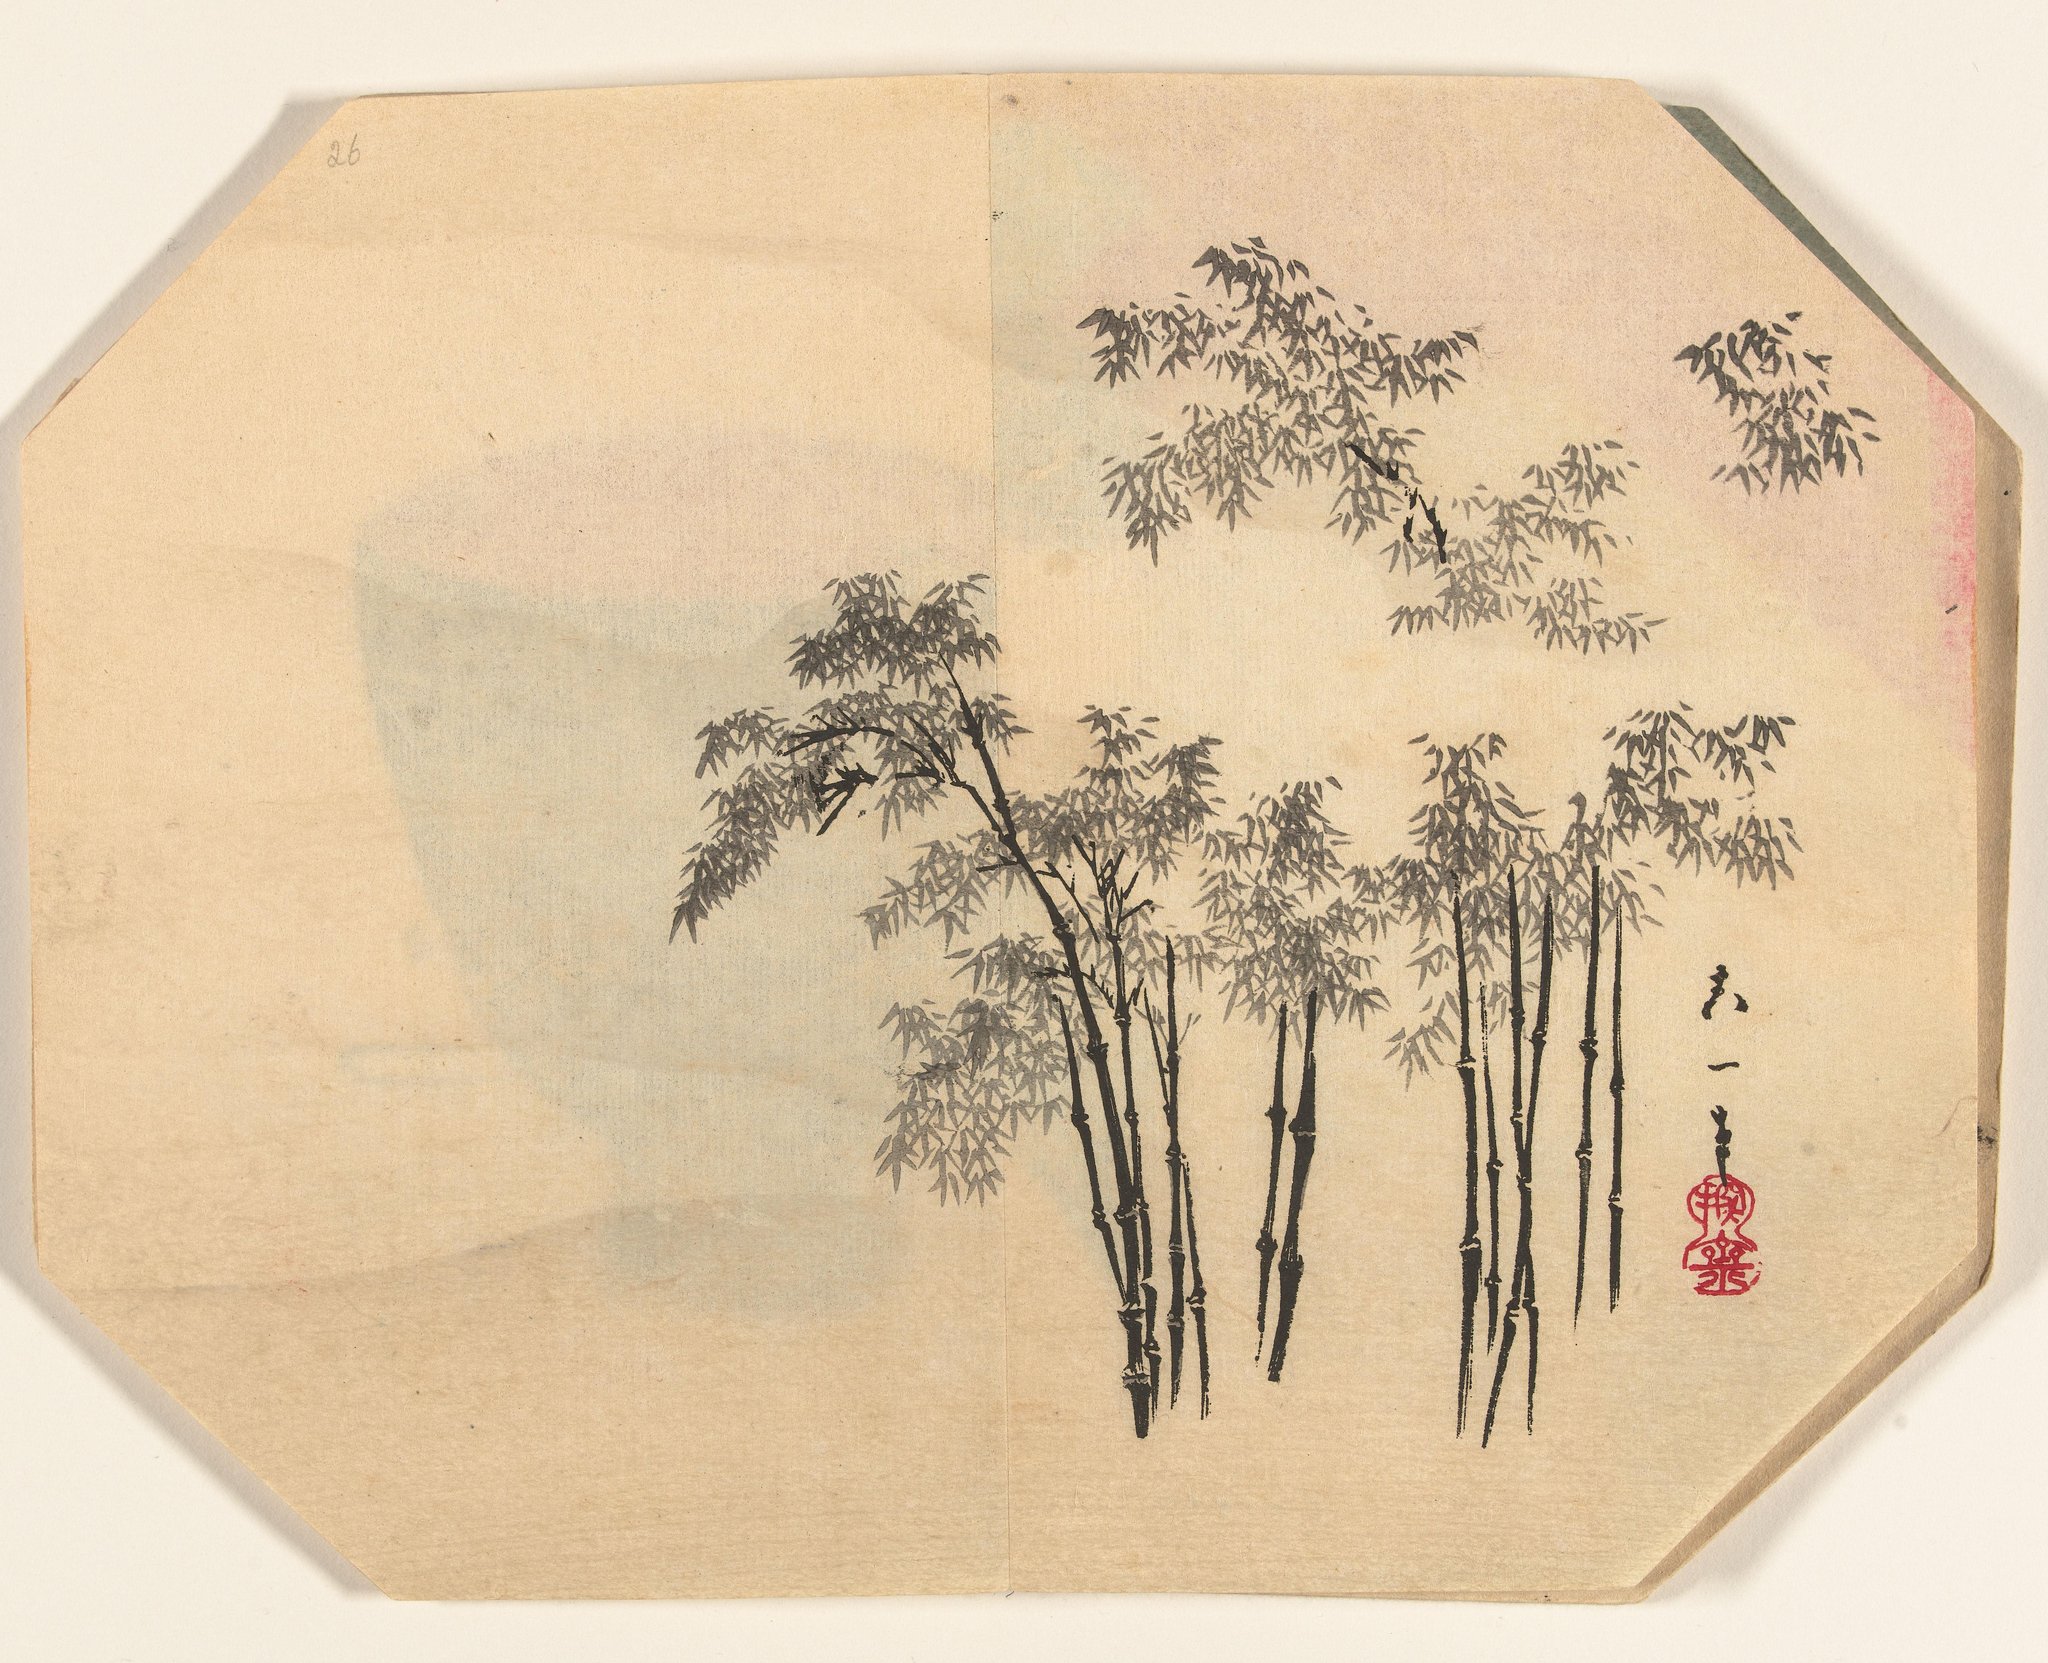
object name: print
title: Bamboe in mist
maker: Anonymous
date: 1880-1890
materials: paper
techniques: woodcut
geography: japan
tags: plants; vegetation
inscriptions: collector's mark: Lugt 2228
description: Octogonale prent in album met 39 prenten.